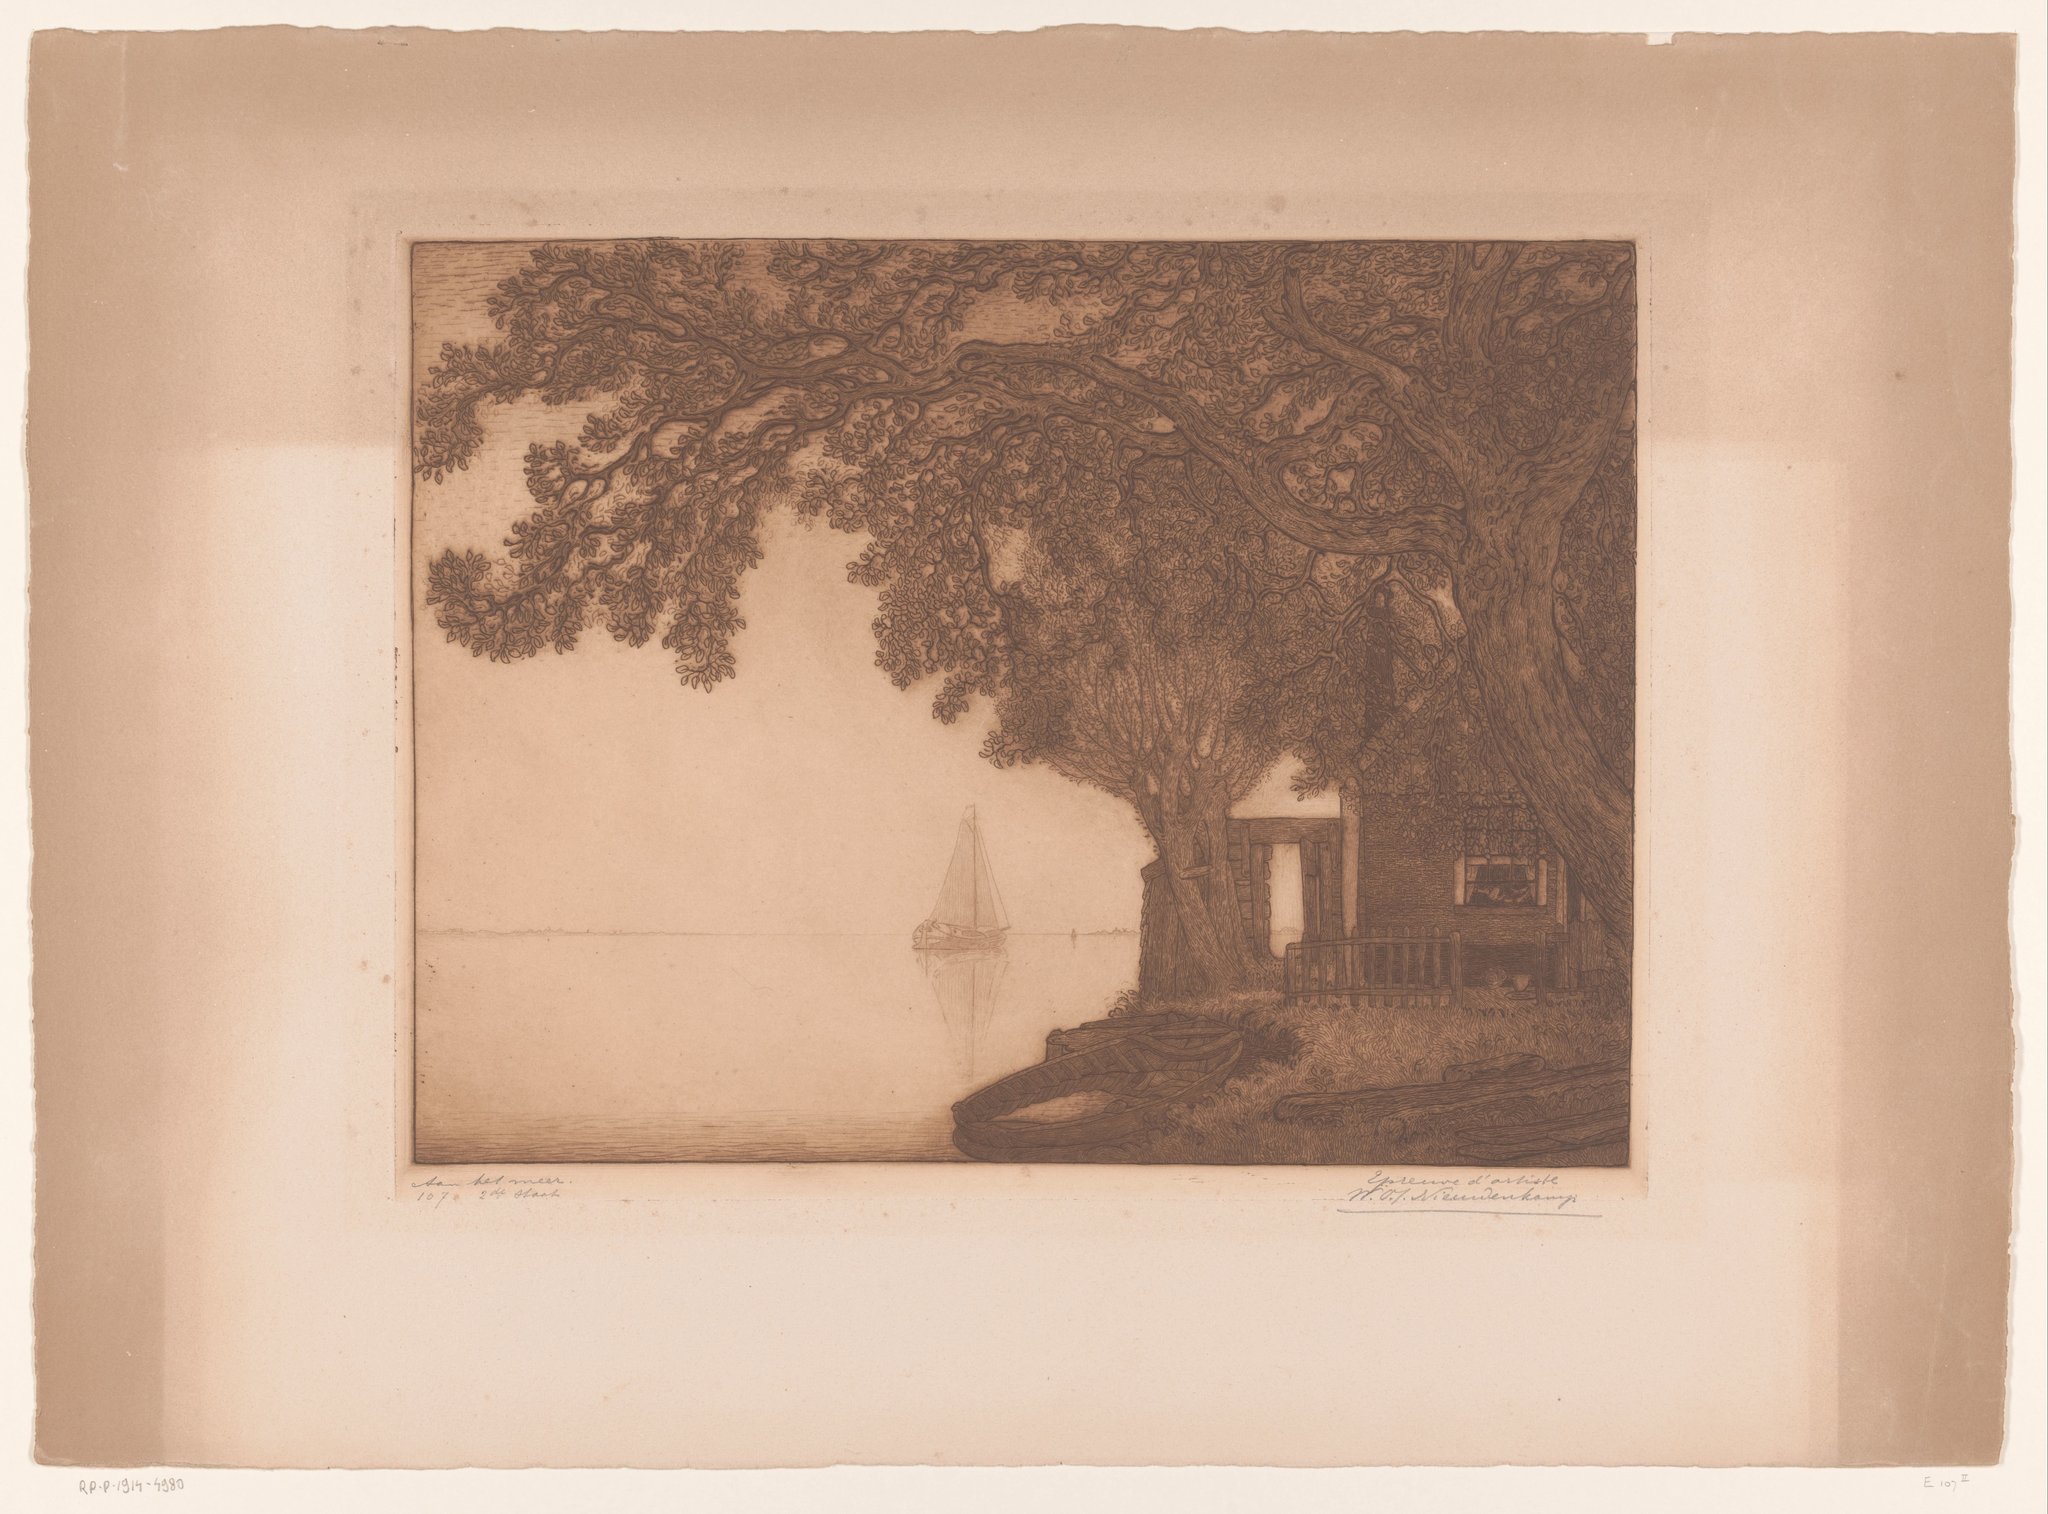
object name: print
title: Aan het meer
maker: wijnand otto jan nieuwenkamp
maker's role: draughtsman, print maker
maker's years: 1874-1950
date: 1909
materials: paper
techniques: drypoint, etching, intaglio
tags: sailing-ship, sailing-boat, lake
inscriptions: collector's mark: Lugt 2233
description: Huis aan een meer met daarop een zeilboot.